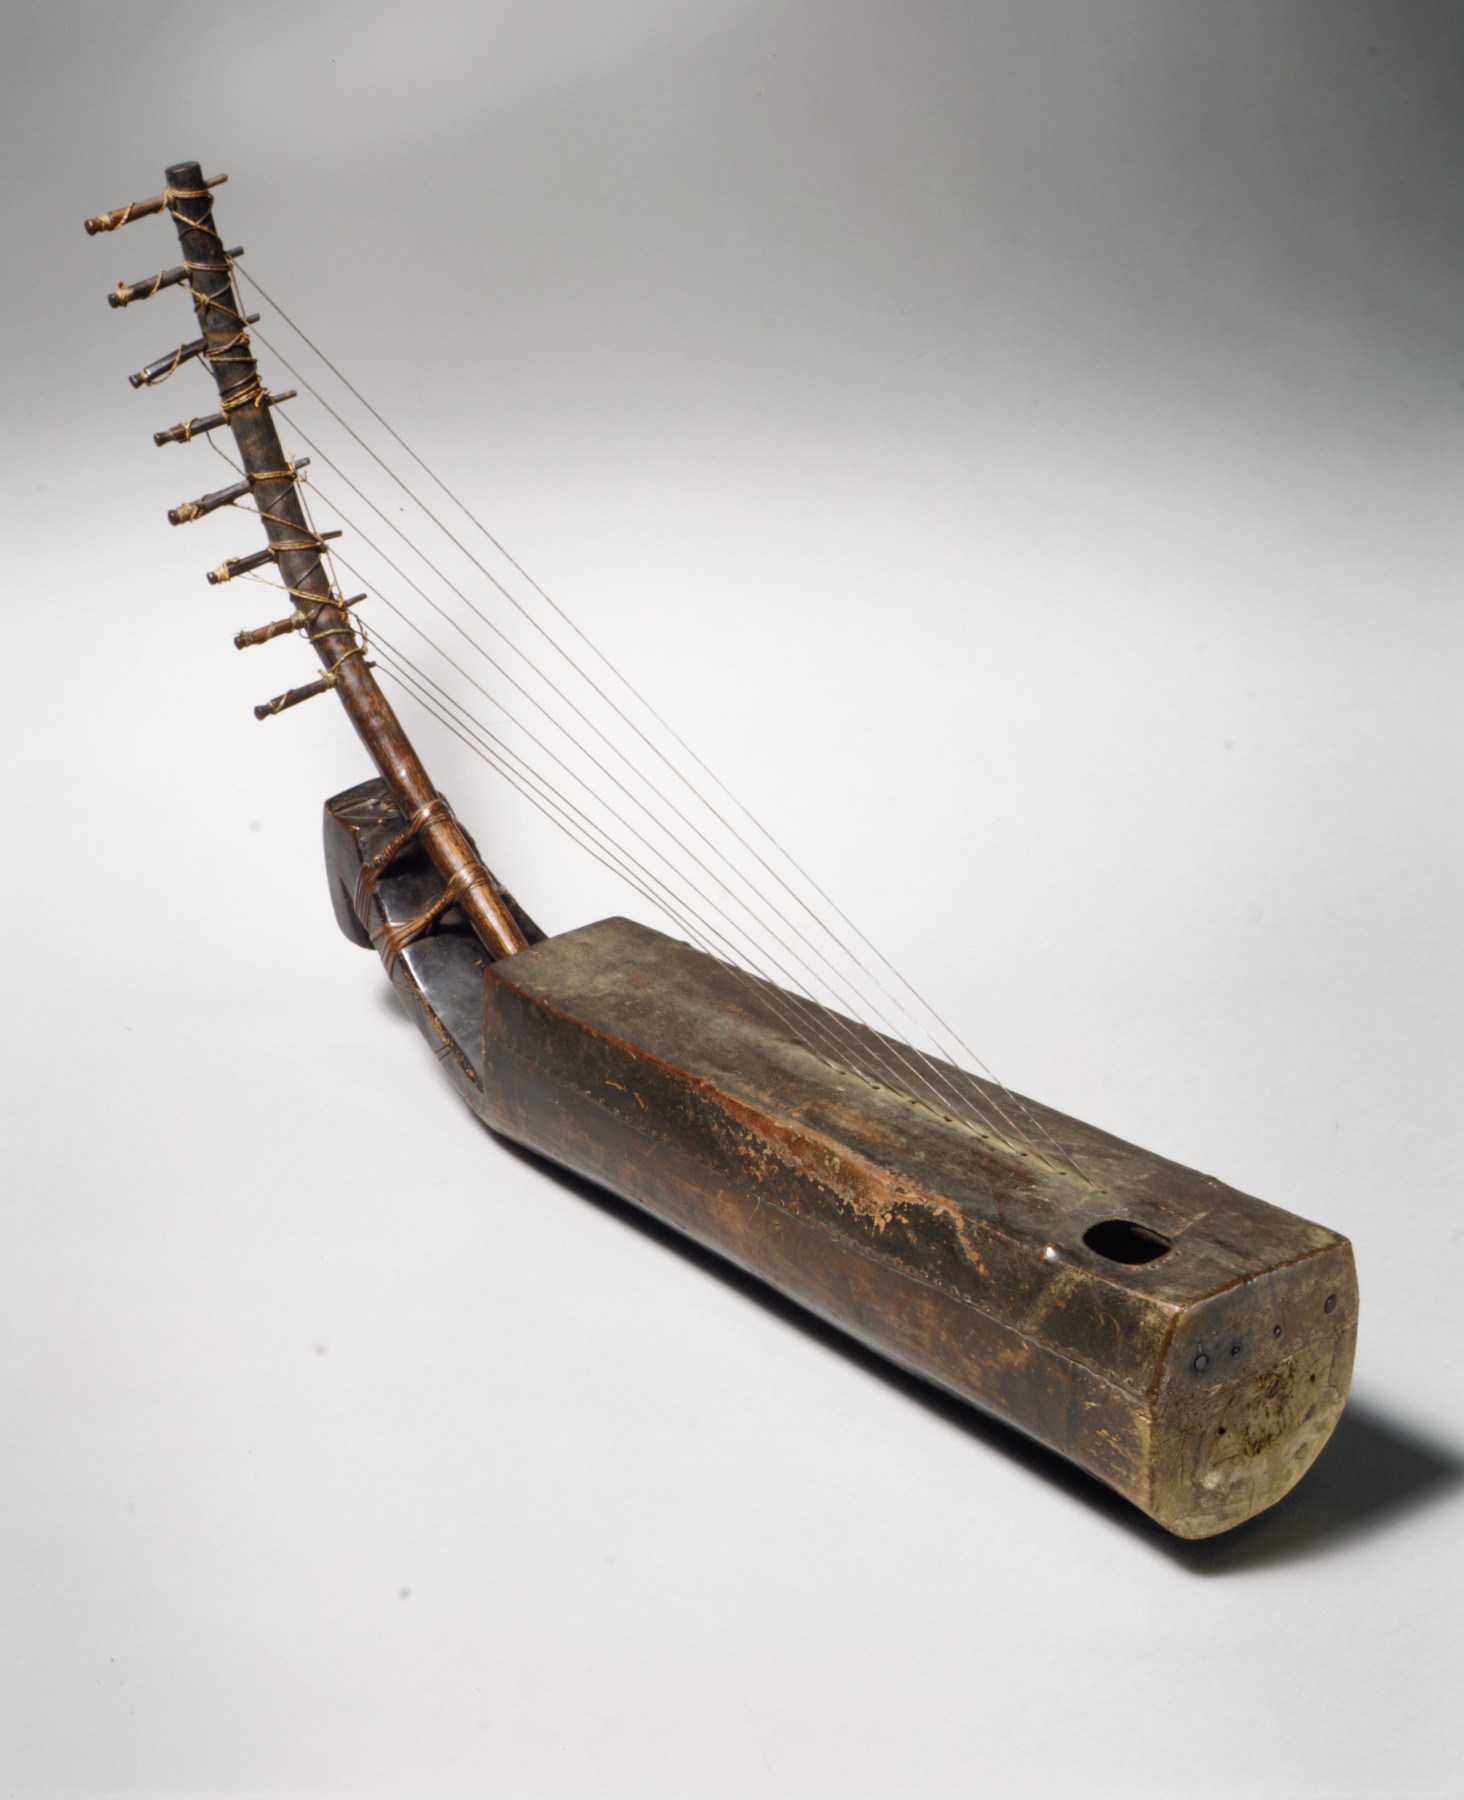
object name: ngombo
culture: tsogo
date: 1801-1900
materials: fiber, skin, wood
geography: gabon